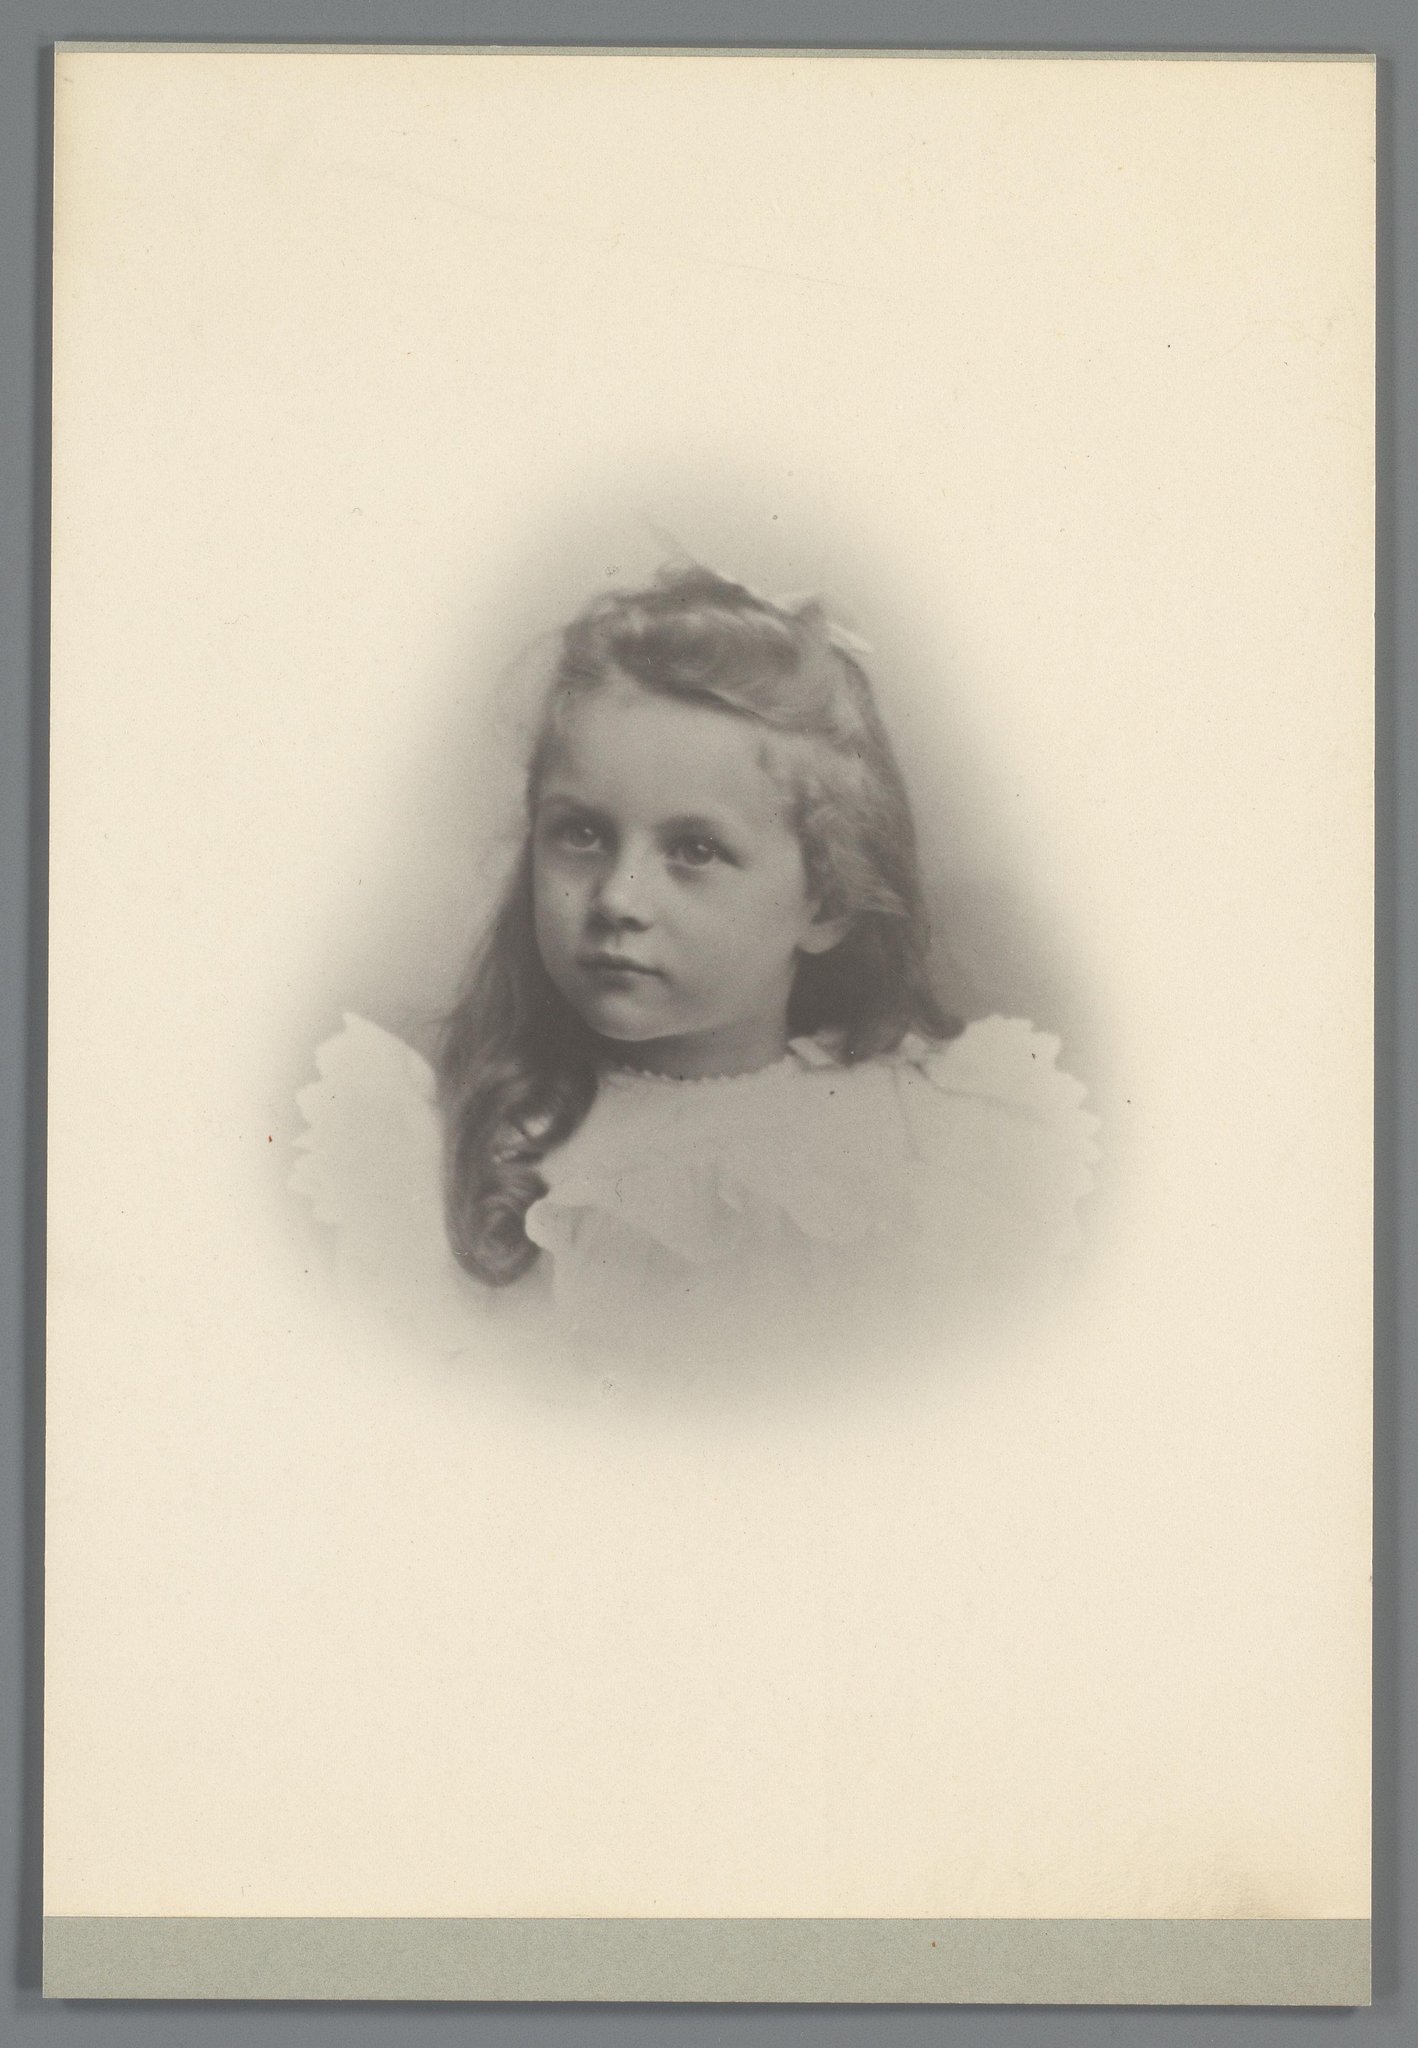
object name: photograph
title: Portret van Johanna (Hans) de Jong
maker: Anonymous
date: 1900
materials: paper, cardboard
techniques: matte daylight collodion silver print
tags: leiden, johanna petronella lambertina stokhuyzen-de jong (hans), historical persons - bb - woman, girl (child between toddler and youth)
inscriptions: inscription: ‘H’, date: ‘ca. 1900.’